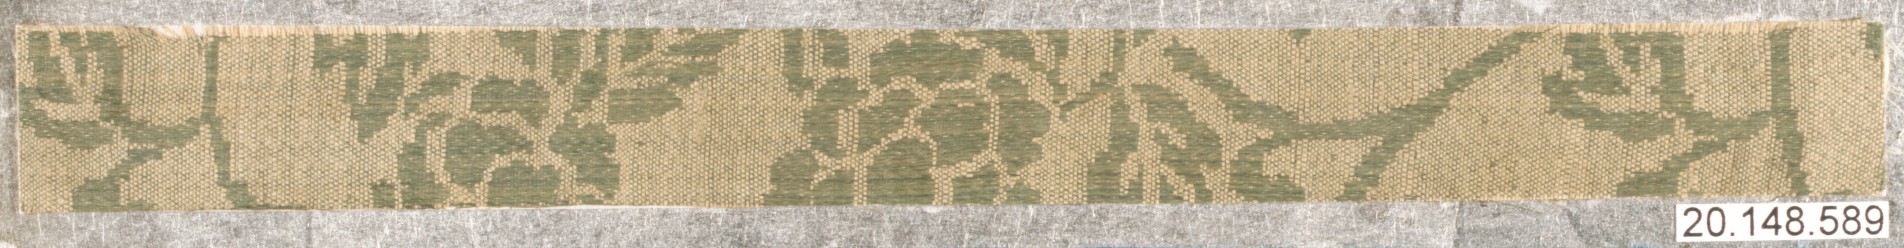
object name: piece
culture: japanese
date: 1701-1800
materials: silk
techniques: compound weave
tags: flowers,leaves